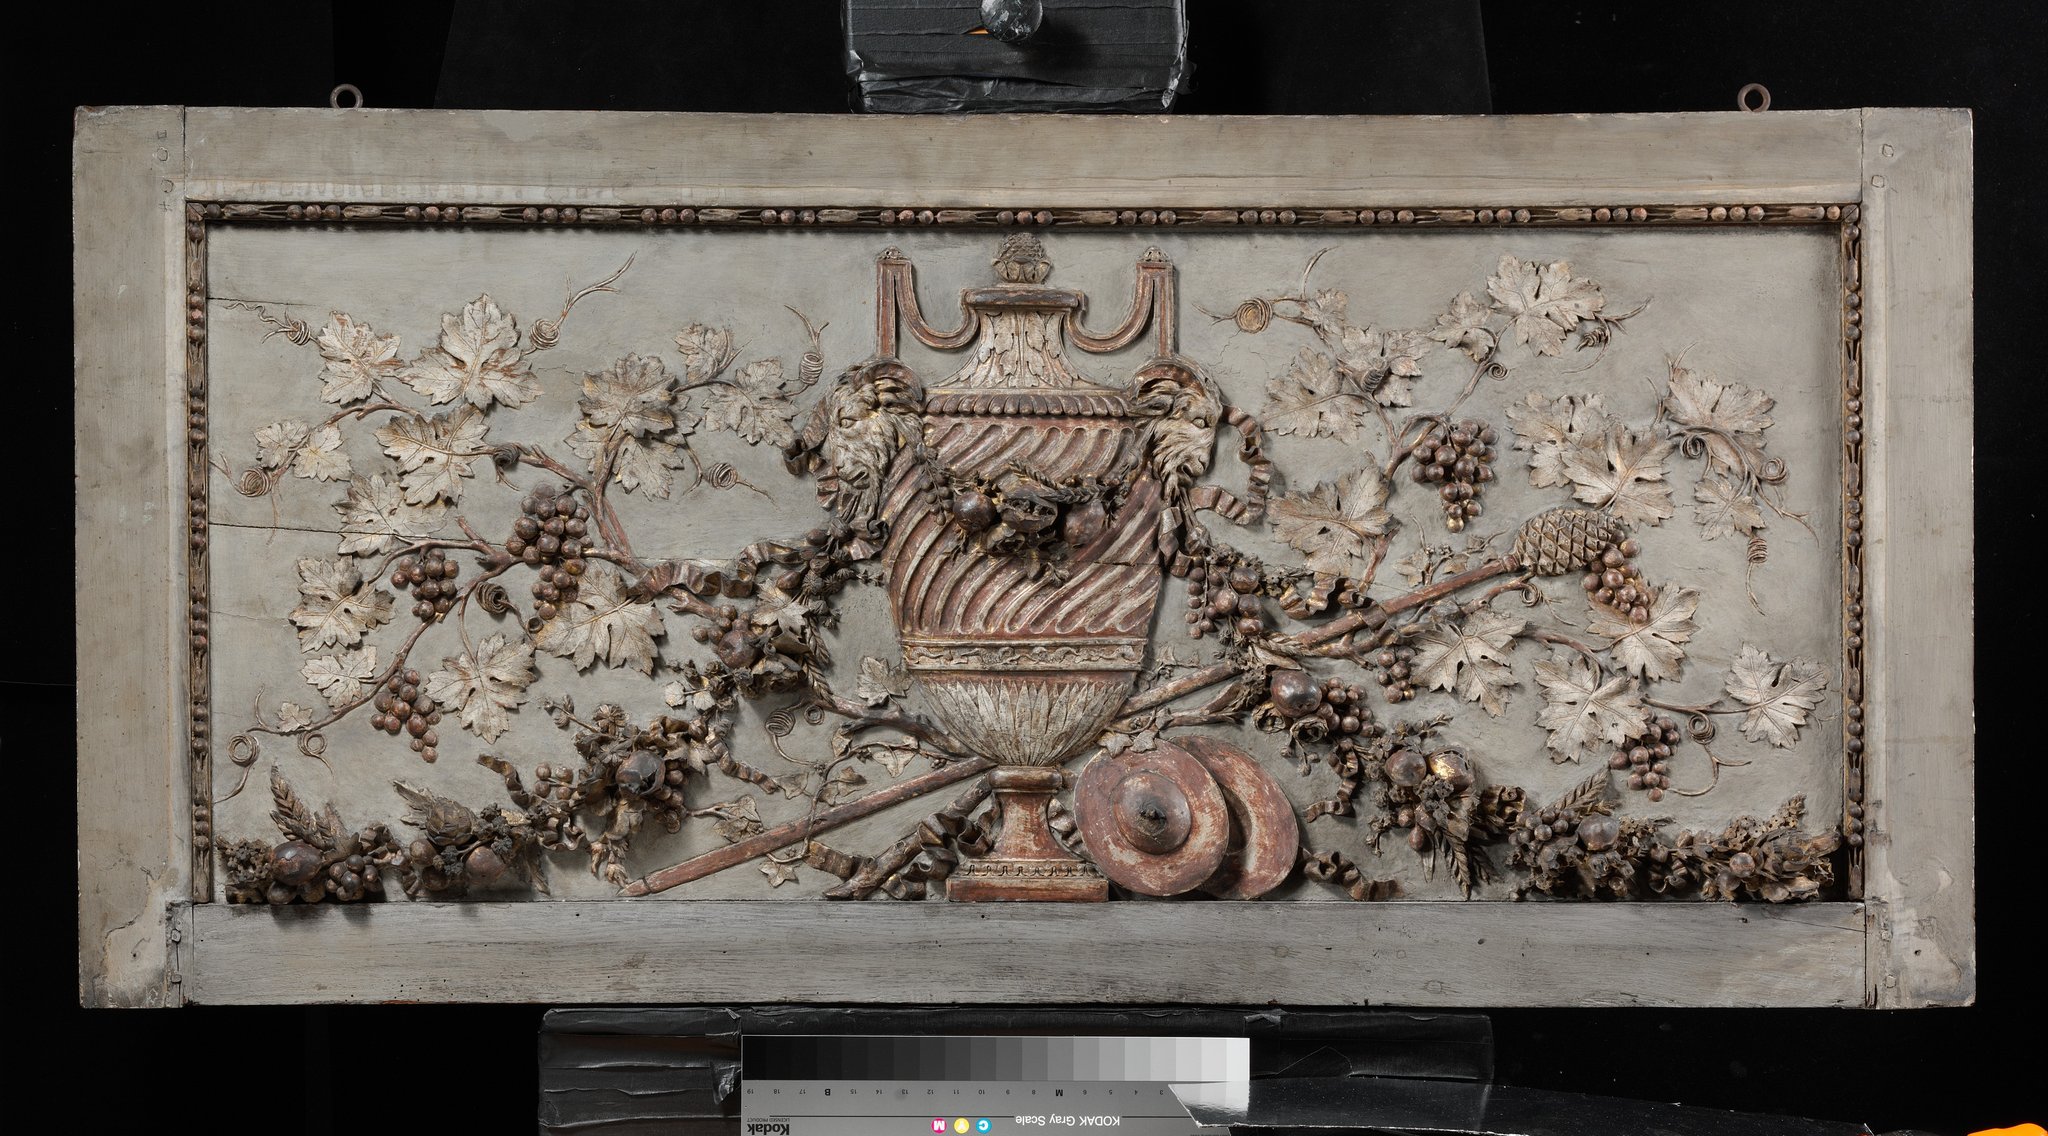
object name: panel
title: Autumn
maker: françois joseph belanger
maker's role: maker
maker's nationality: french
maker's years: 1744-1818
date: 1775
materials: gilt, wood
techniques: carving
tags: animals,garlands,grapes,leaves,autumn